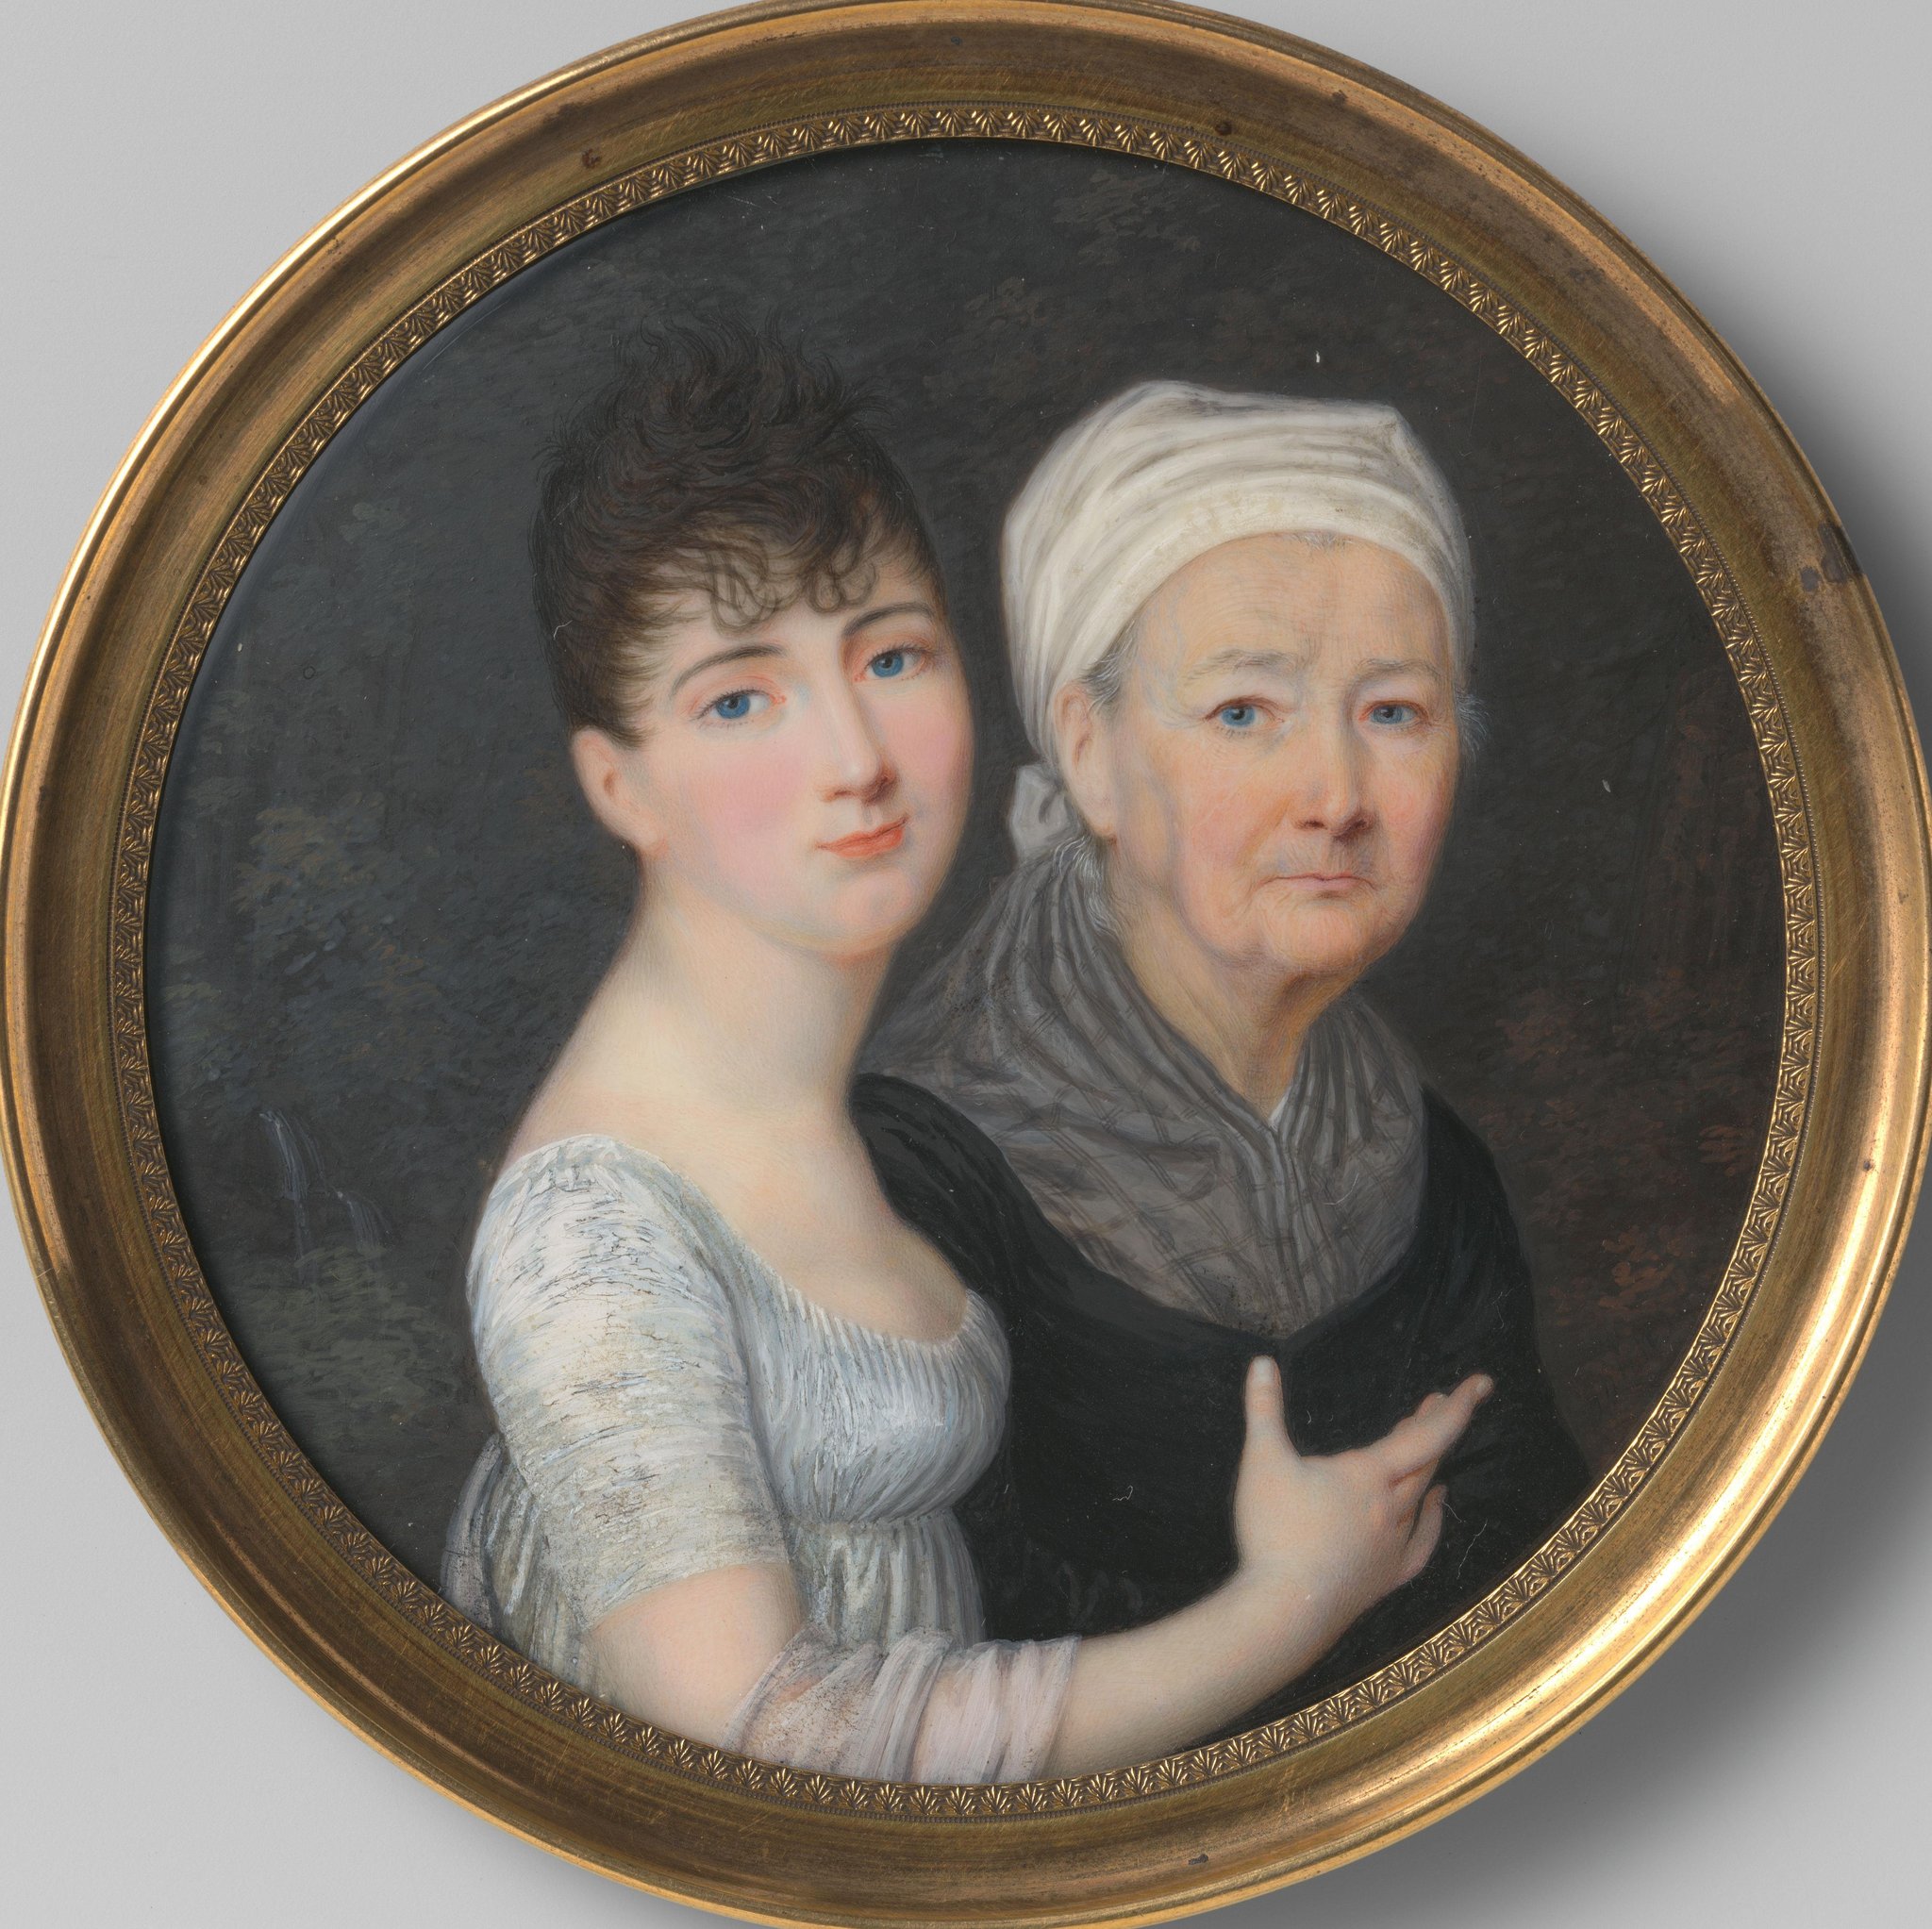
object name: painting, miniature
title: Portrait of an Old and a Young Woman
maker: johns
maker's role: miniatuurschilder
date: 1790-1810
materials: glass, metal, parchment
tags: historical persons not known by name - bb - woman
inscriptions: signature: ‘Johns’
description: Johns (active c. 1790 - 1810). Portrait of an old and a young woman. Vellum, c. 1805. Mr and Mrs J.C.J. Drucker-Fraser bequest, Montreux, 1944.